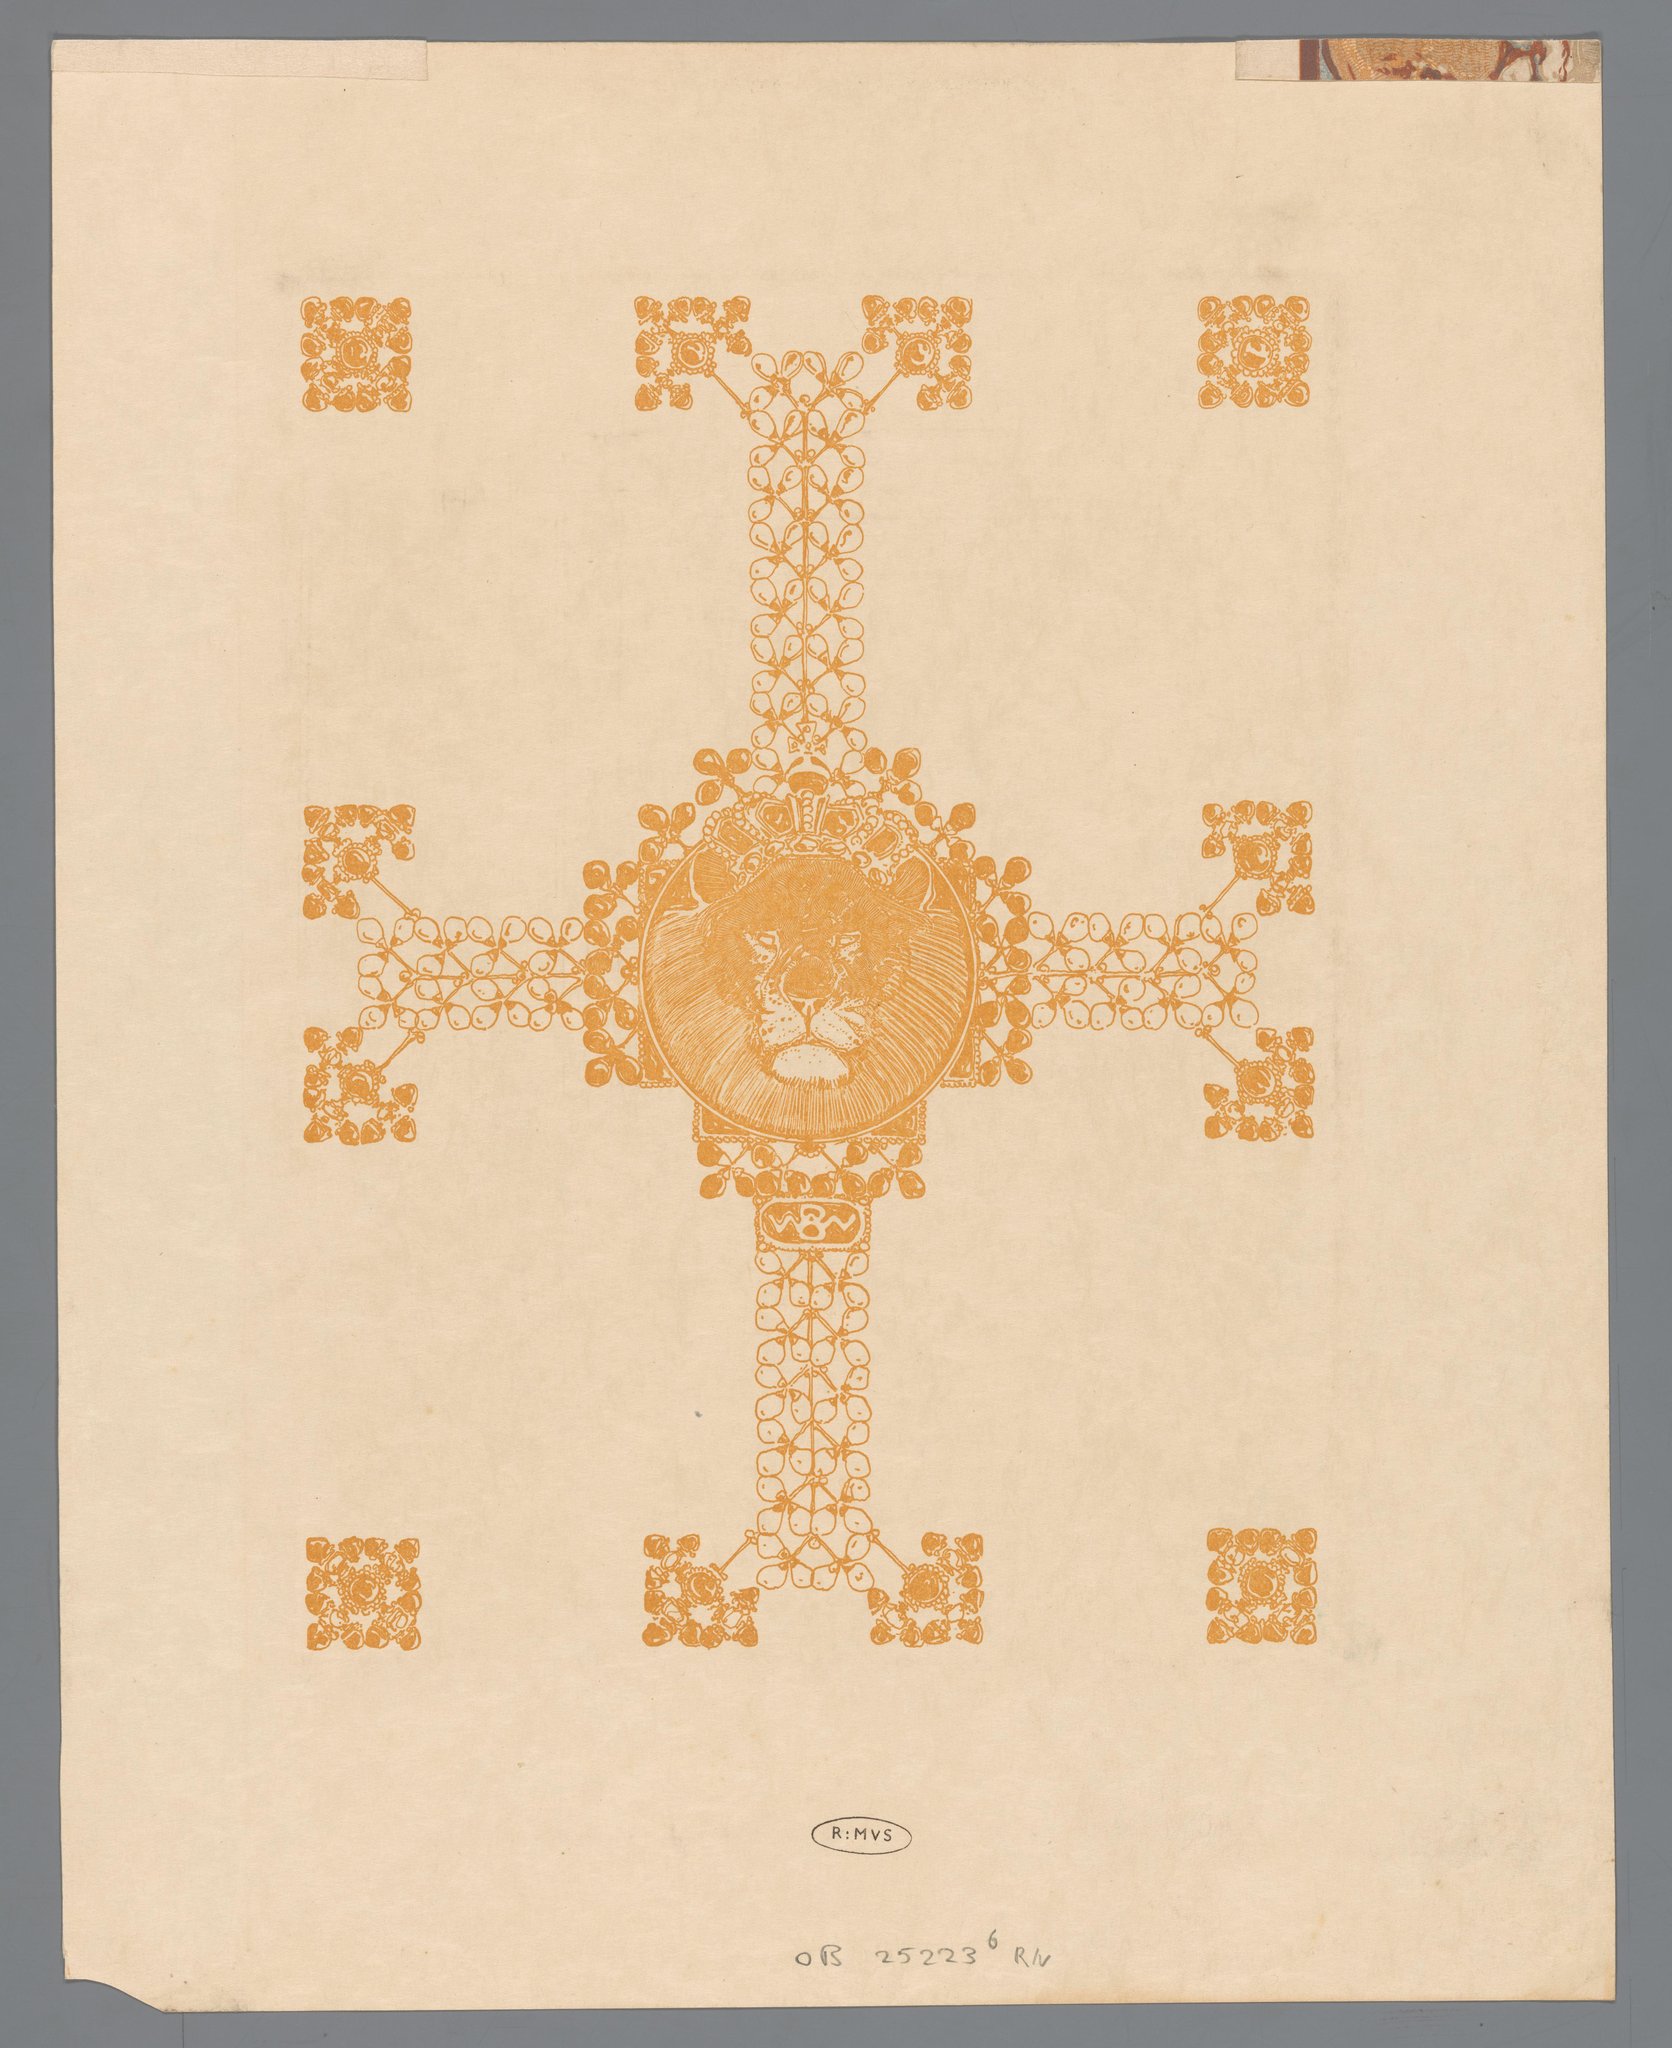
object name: book illustration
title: Ornamentiek en gekroonde leeuw (Nobel)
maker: bernard willem wierink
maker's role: draughtsman, print maker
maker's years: 1856-1939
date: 1910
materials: paper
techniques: lithograph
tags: fable of reynard the fox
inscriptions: collector's mark: Lugt 2228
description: Prent gebruikt in: Streuvels, Stijn (Frank Lateur). Reinaert de Vos naar verschillende uitgaven van het middeleeuwsche epos. Amsterdam: L.J. Veen, 1910.